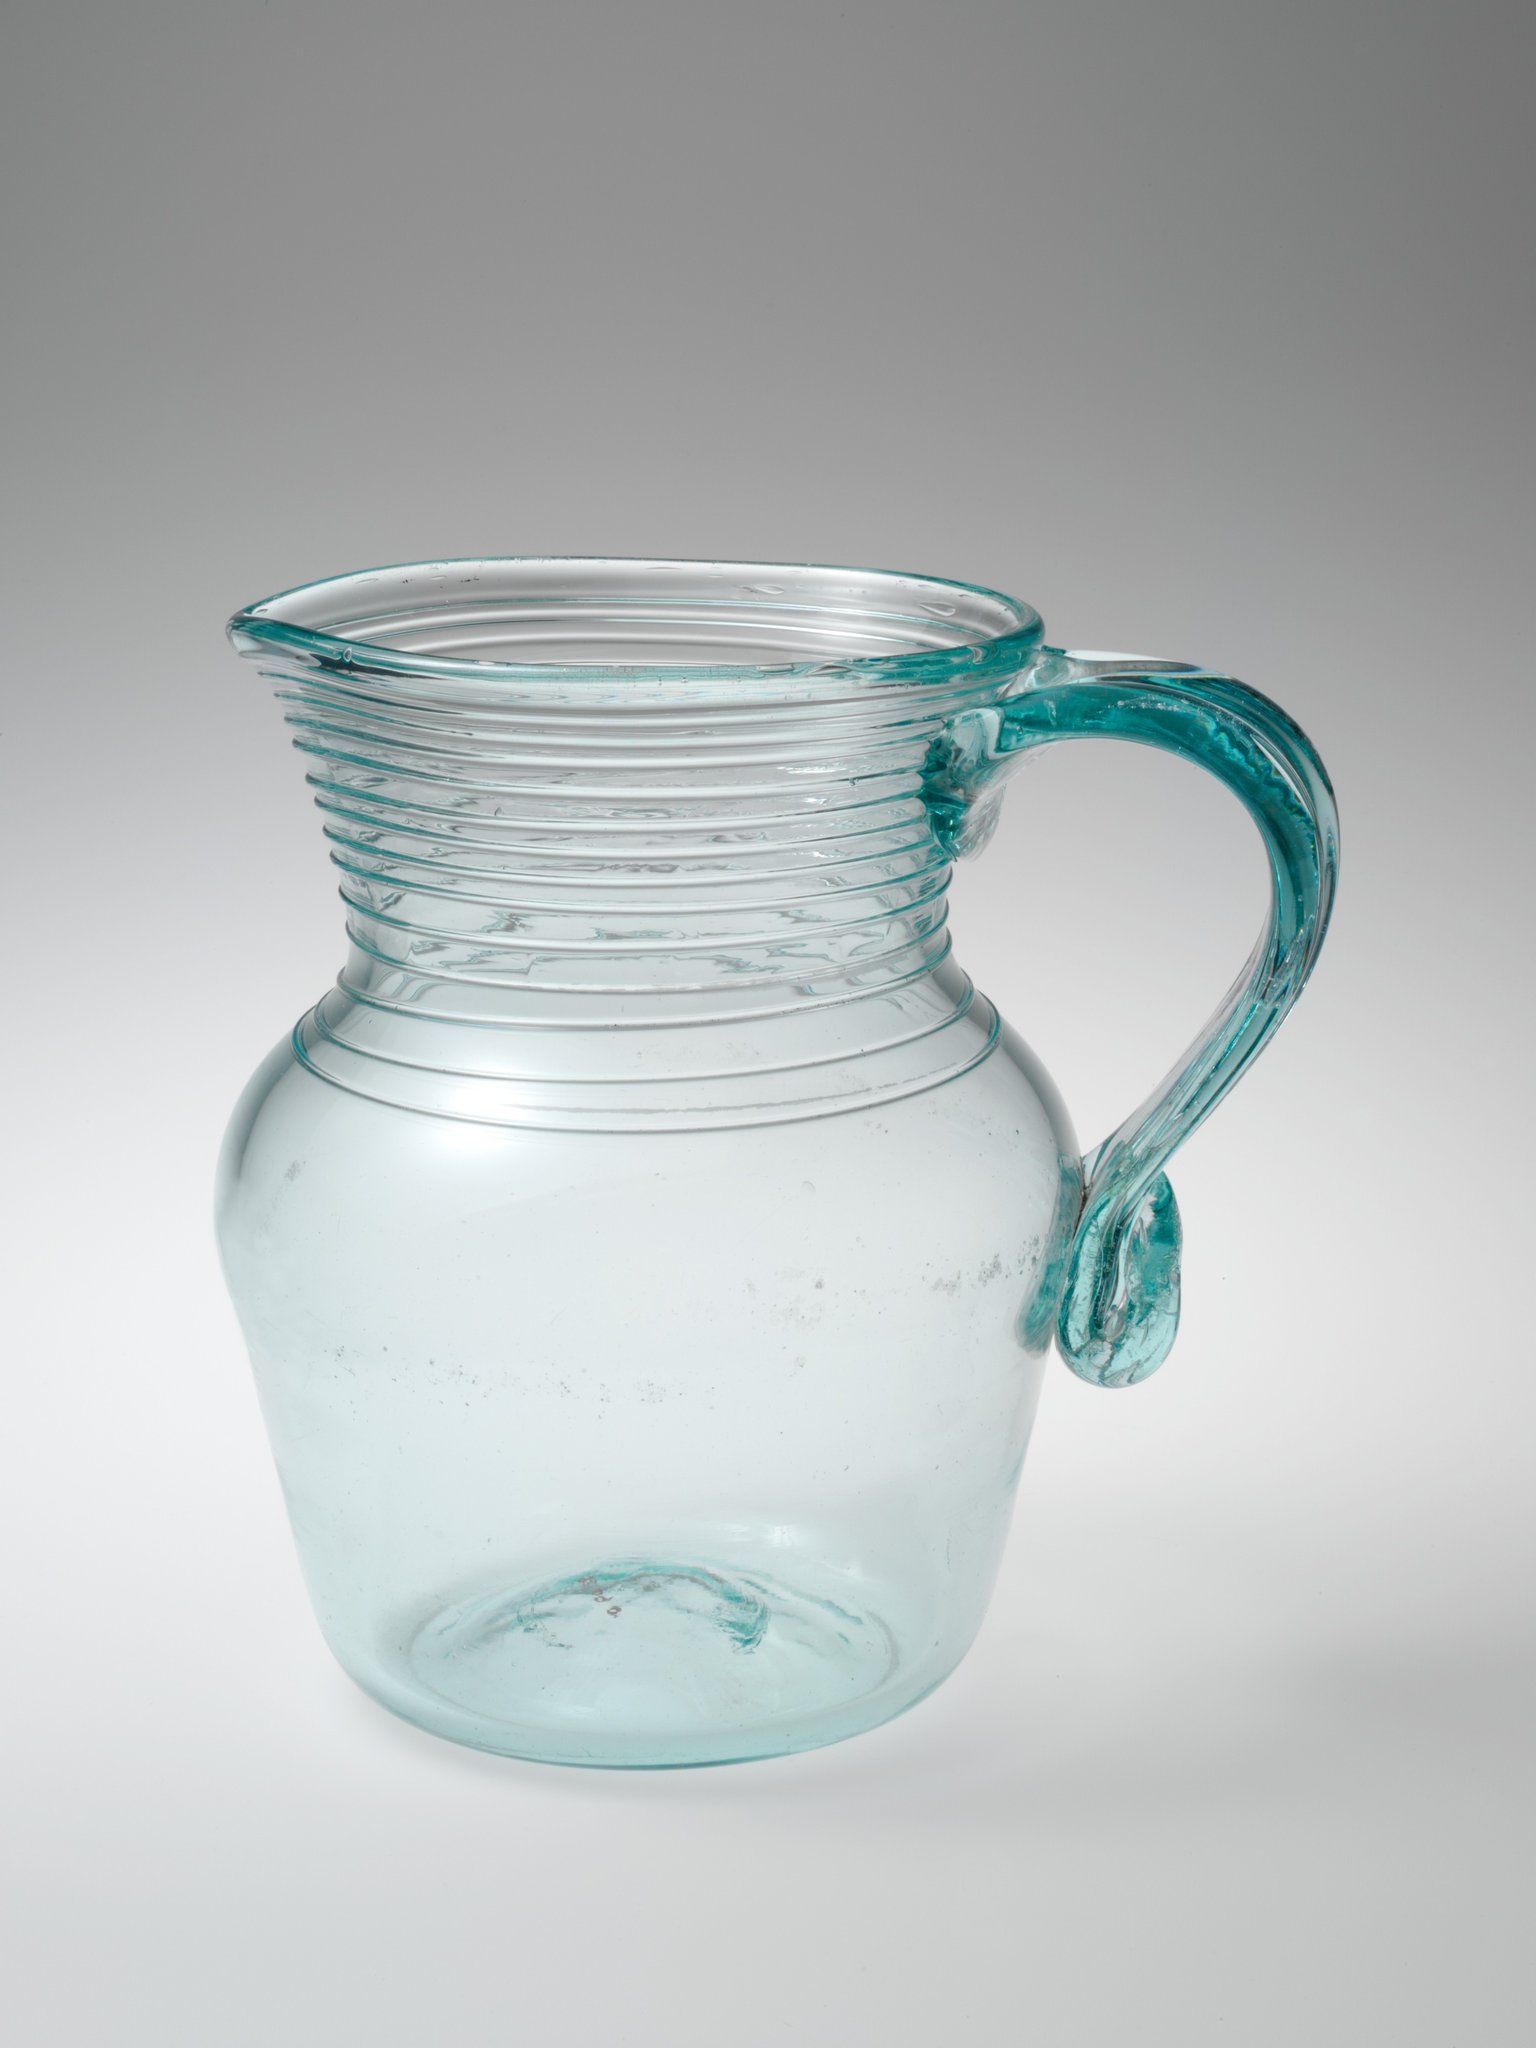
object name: pitcher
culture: american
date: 1830-1865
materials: glass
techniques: glassblowing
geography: united states